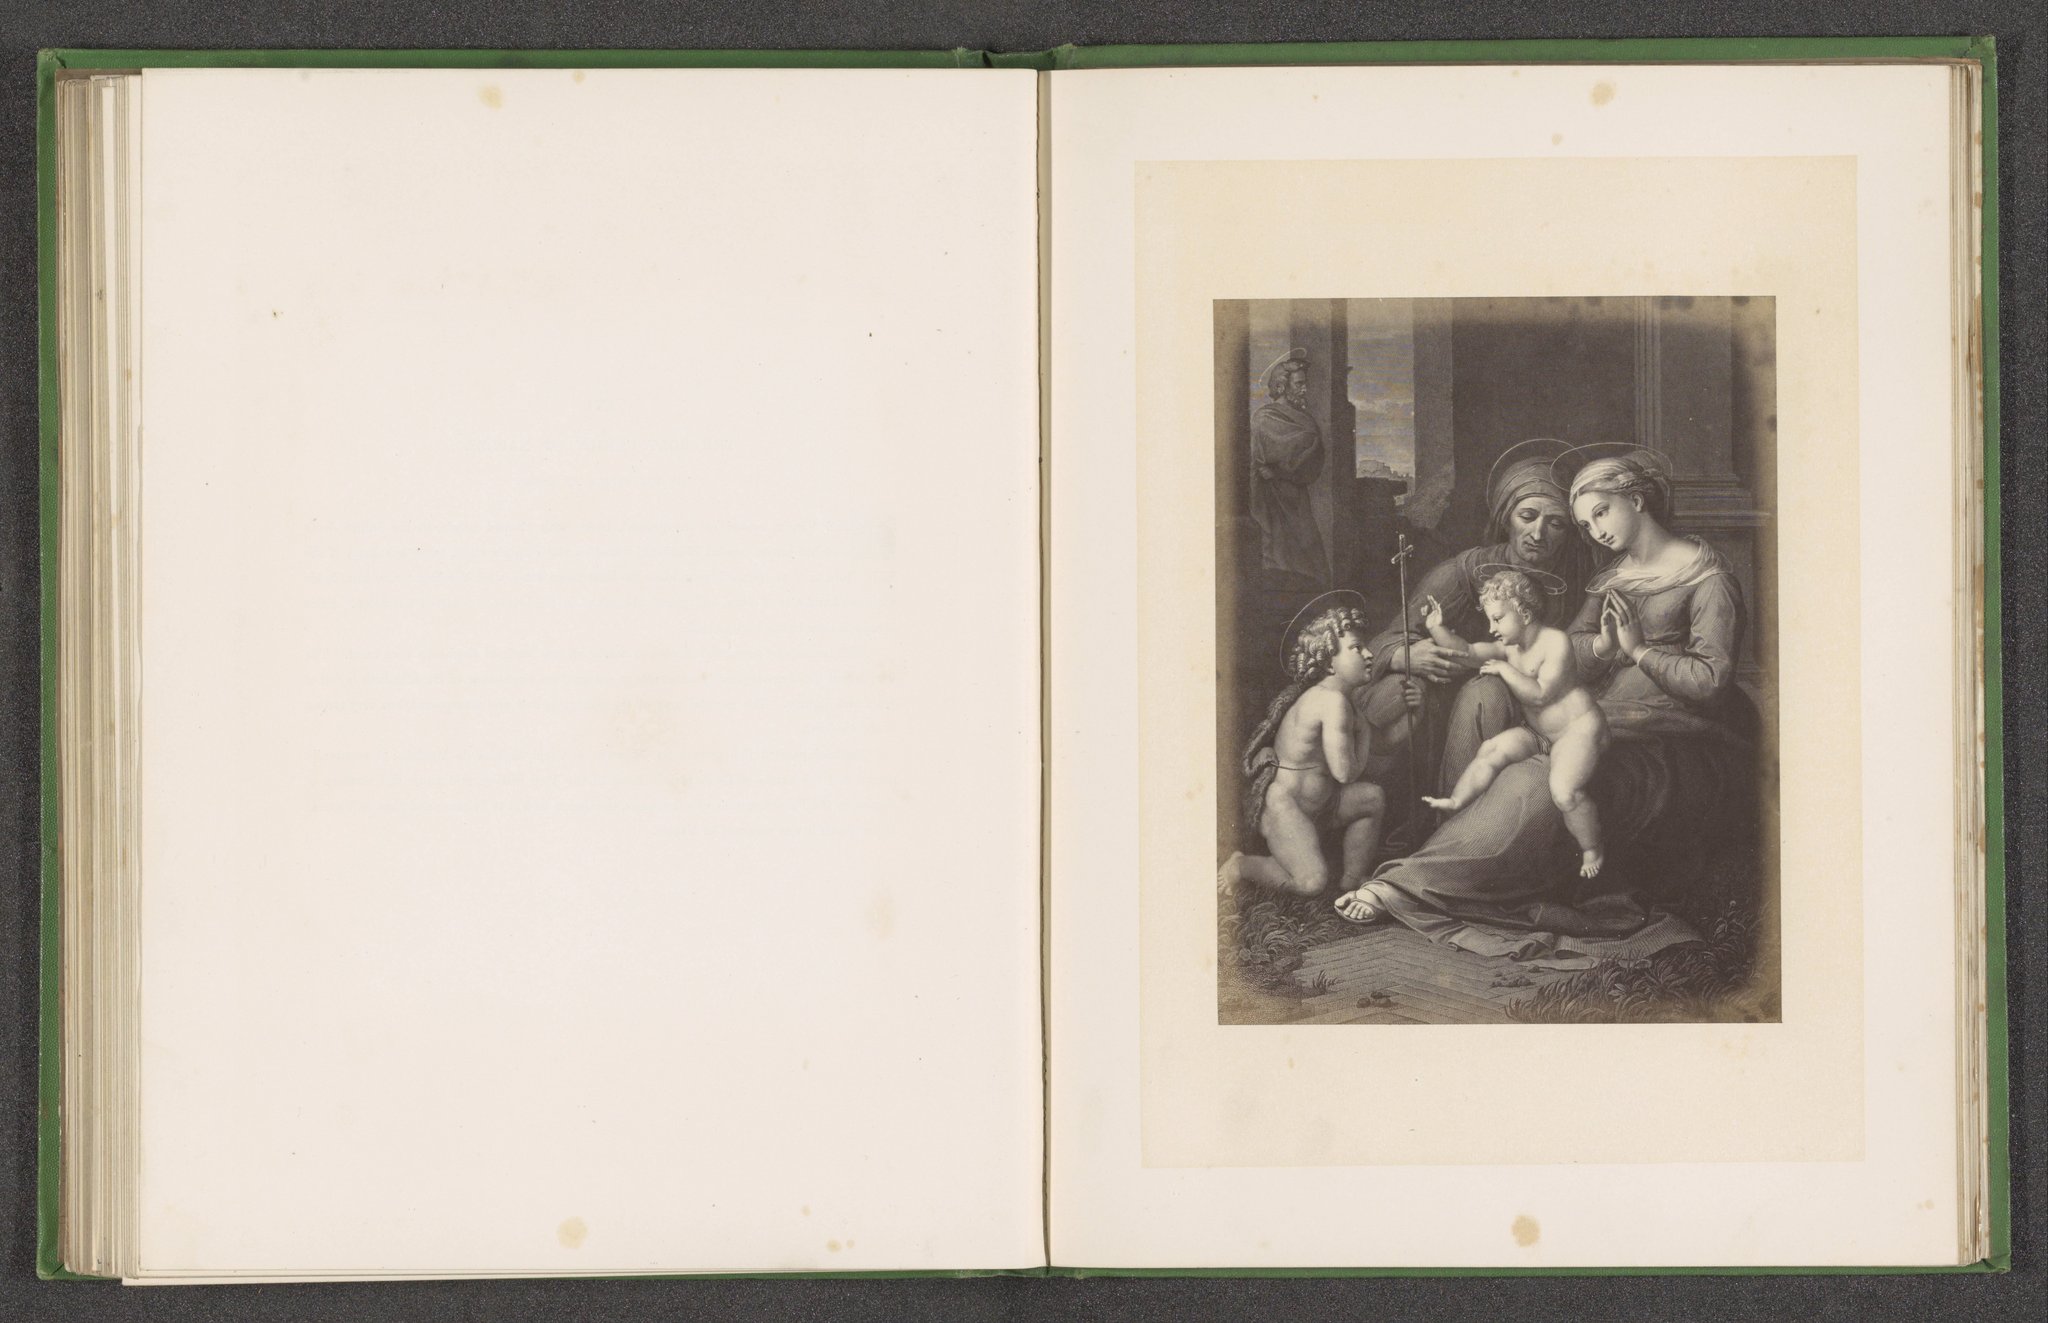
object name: reproduction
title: Fotoreproductie van een prent door Constant-Louis-Antoine Lorichon van de Madonna del Divino amore door Rafaël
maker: joseph cundall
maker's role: fotograaf, schrijver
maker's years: 1818-1895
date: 1859-1869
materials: photographic support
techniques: albumen print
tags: holy family, and derived representations